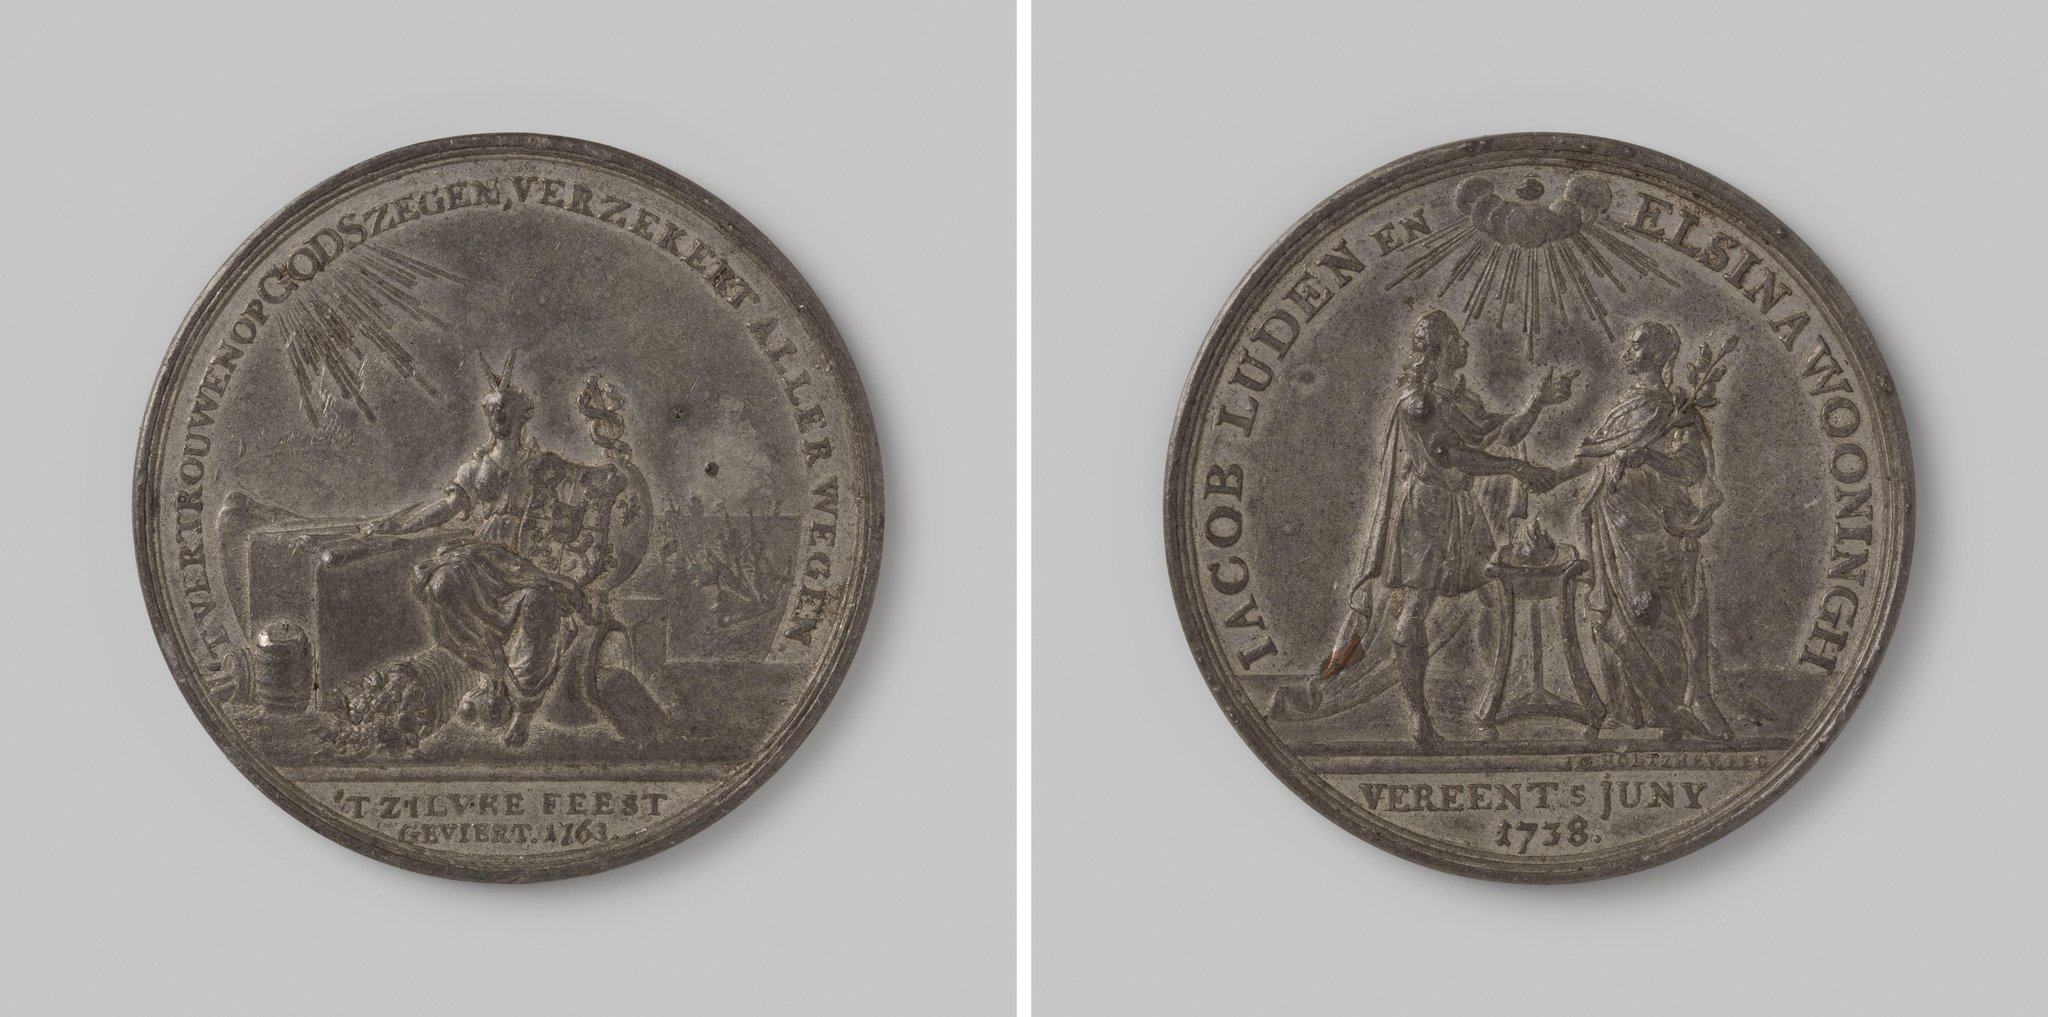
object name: history medal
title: Vijfentwintigjarig huwelijk van Jacob Luden en Elisabeth Wooningh 1763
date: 1763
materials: tin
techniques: striking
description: Tinnen penning, op de voorzijde een vrouw met twee familiewapens, zittend op een hoorn des overvloeds en een uitstromende urn, een oorkonde tekenend te midden van handelssymbolen, met omschrift en afsnedetekst, op de keerzijde het echtpaar in Romeinse kleding, elkaar de hand drukkend boven een brandende driepoot onder het stralende oog Gods, met omschrift en afsnedetekst.